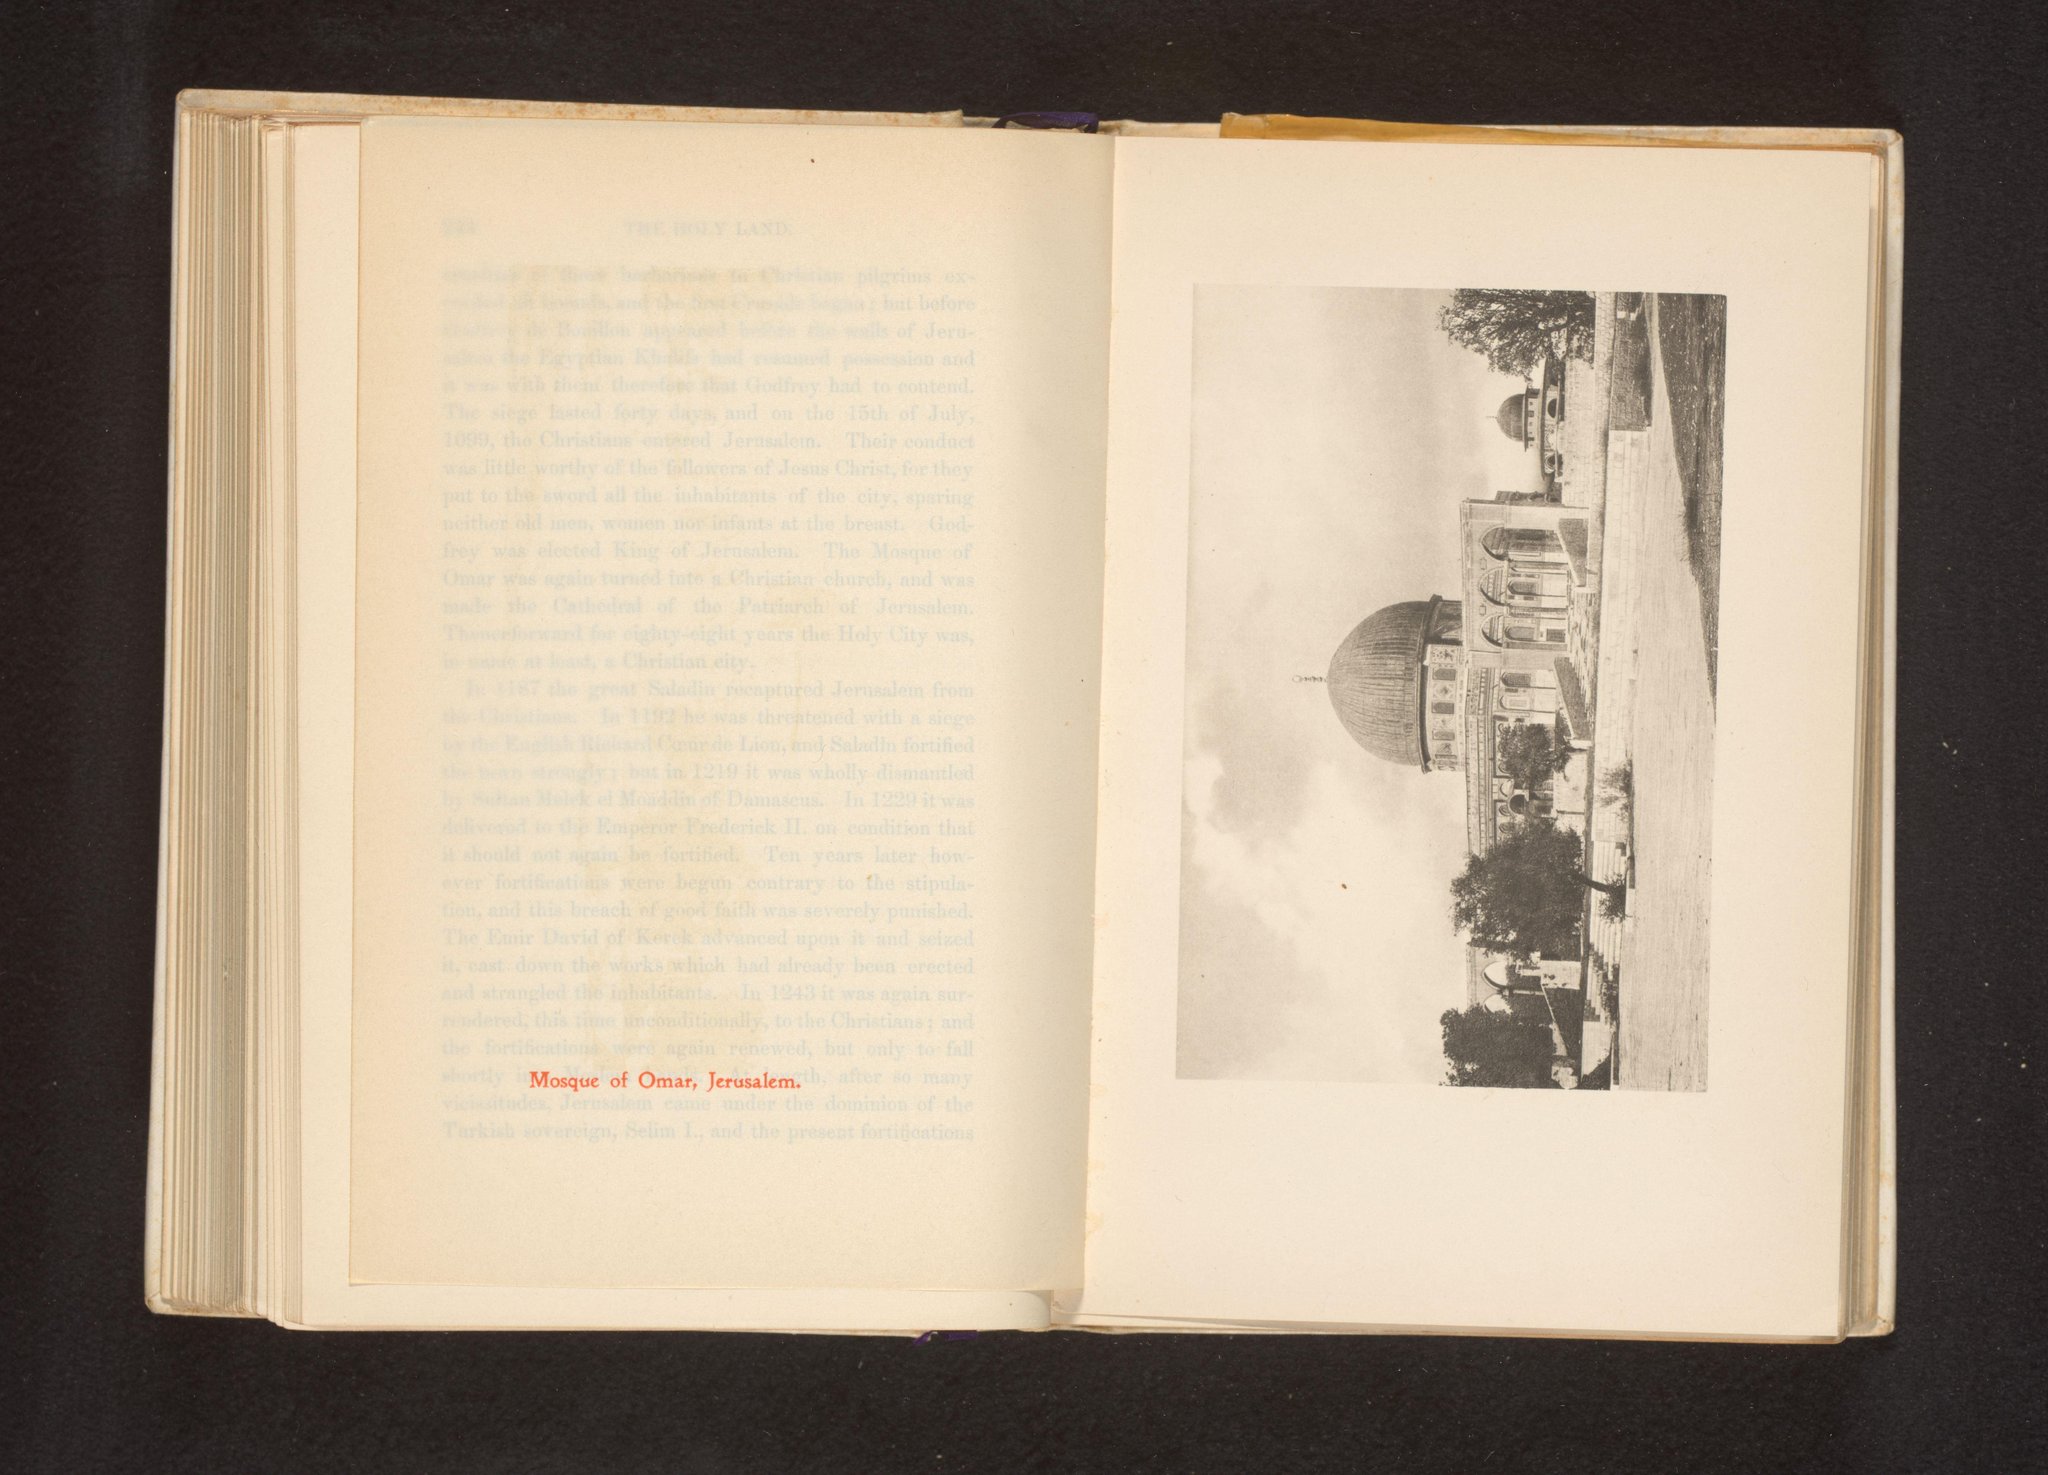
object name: page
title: Exterieur van de Omarmoskee te Jeruzalem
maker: Anonymous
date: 1890-1900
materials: paper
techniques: photoaquatint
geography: jerusalem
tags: temple, shrine ~ islam, mohammedanism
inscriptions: title: ‘Mosque of Omar, Jerusalem.’